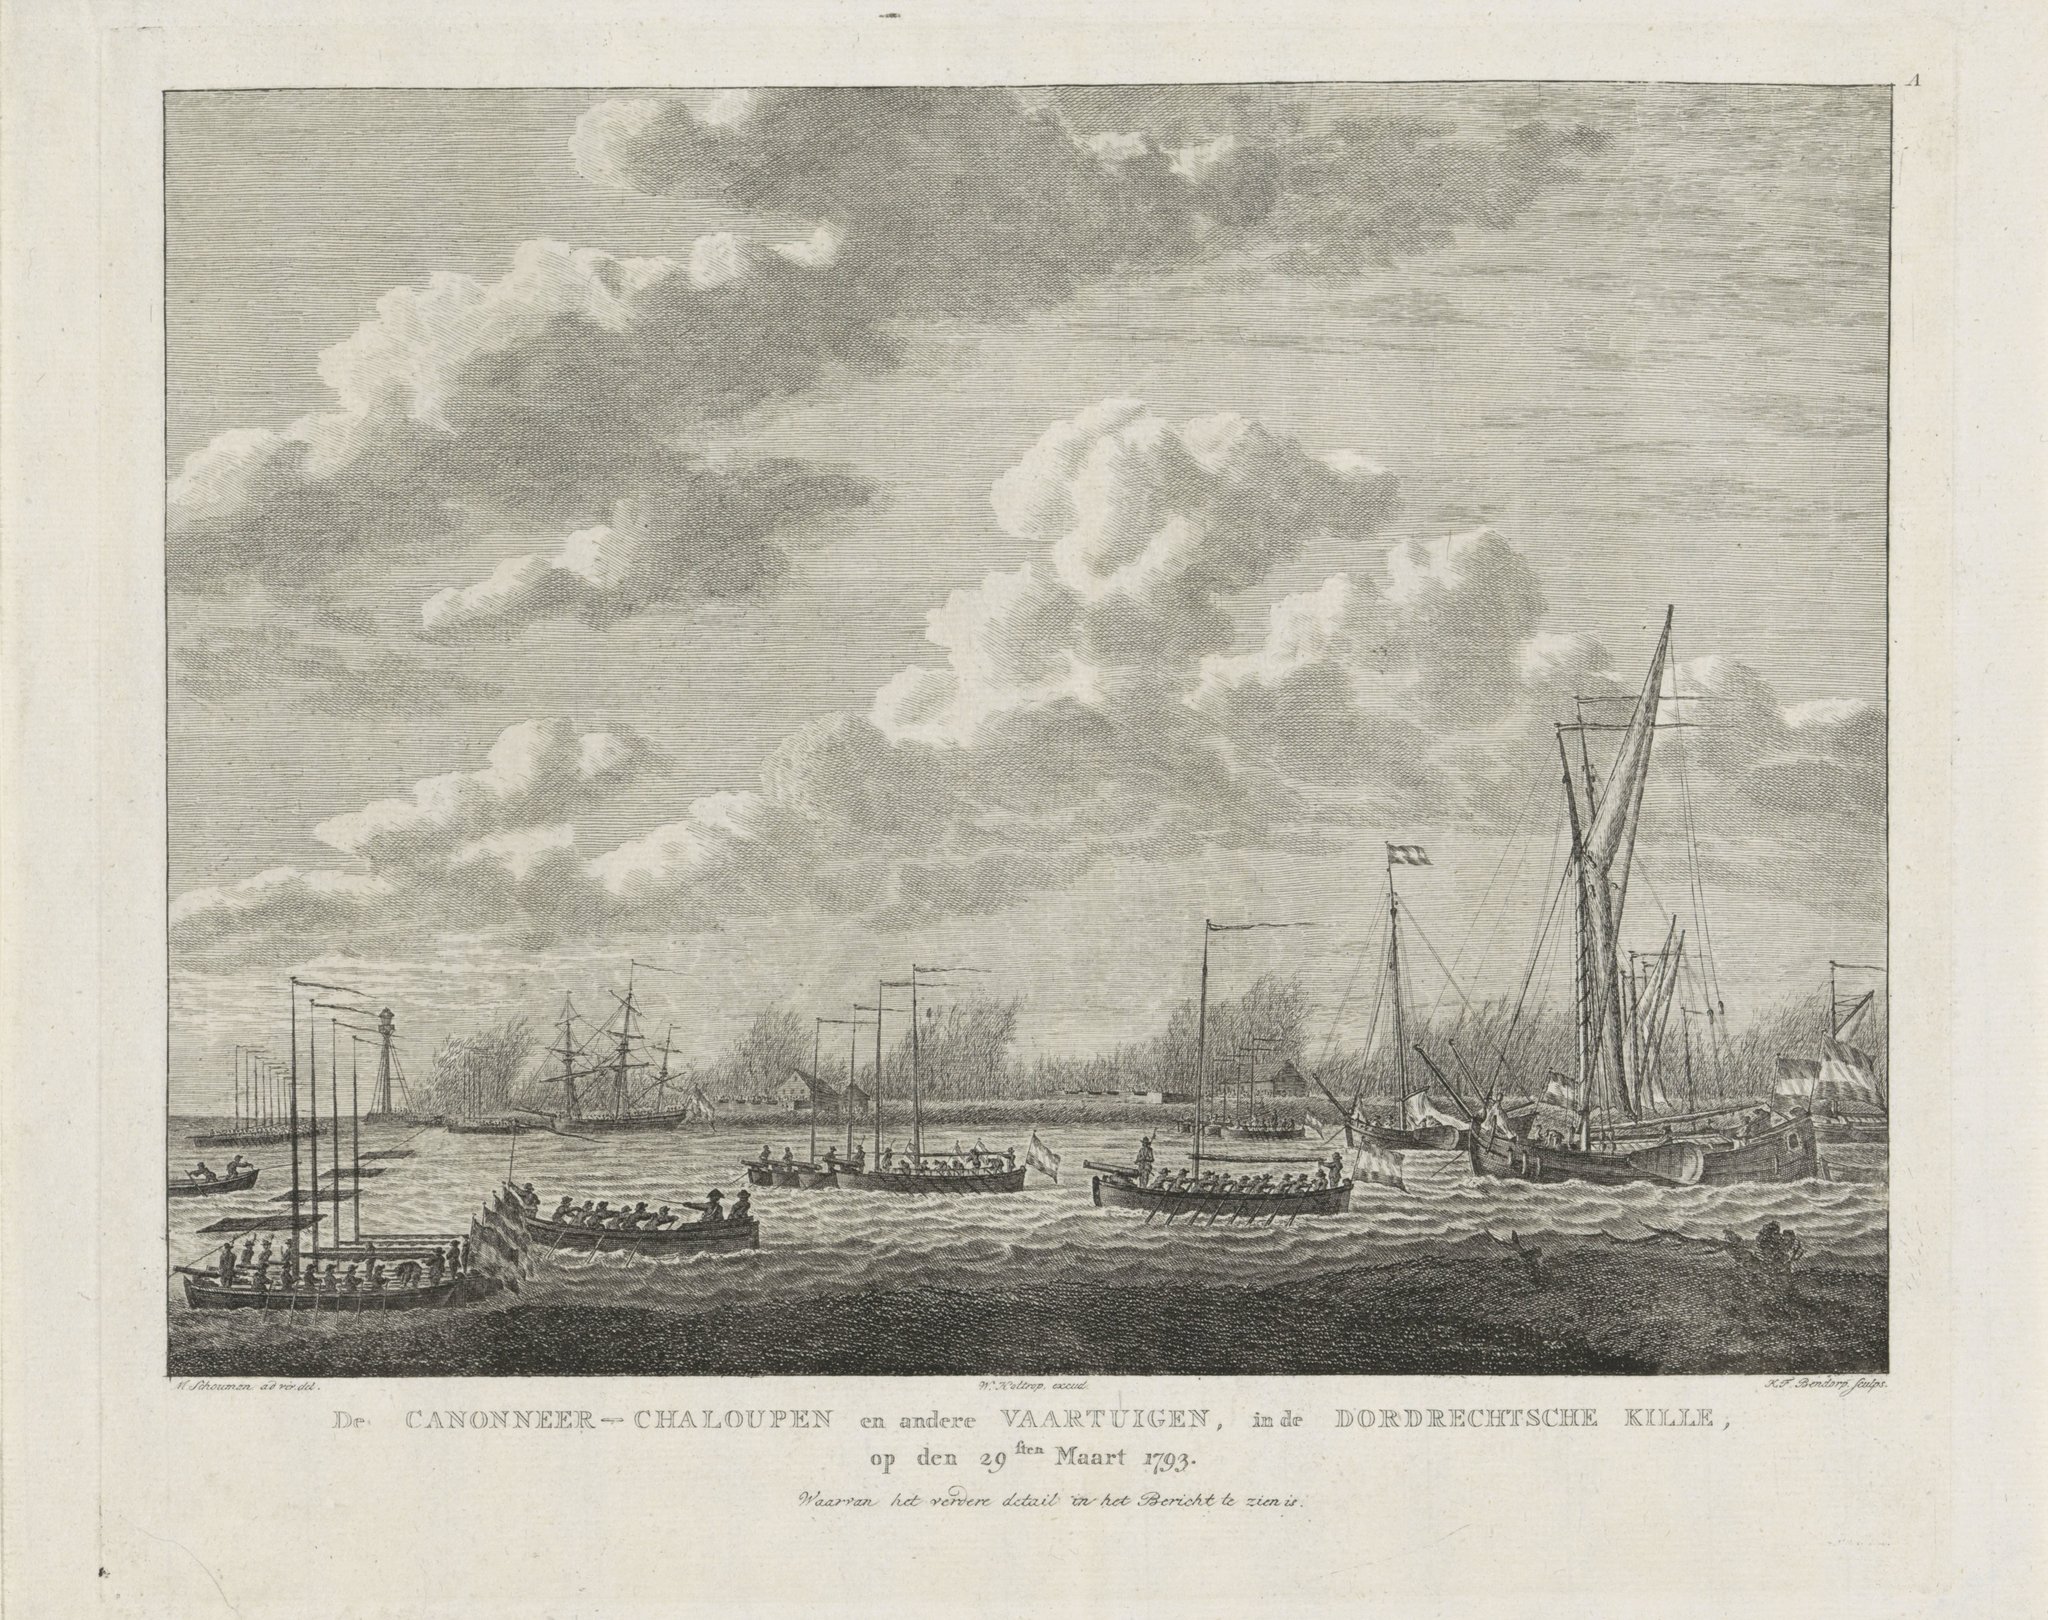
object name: print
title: Kanonneersloepen in de Dordtsche Kil, 1793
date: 1793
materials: paper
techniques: engraving, etching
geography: dordtse kil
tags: chains across waterway, rowing-boat, canoe, etc.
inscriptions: collector's mark: Lugt 2228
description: De afsluiting van de Dordtsche Kil met vlotten, kanonneersloepen en enkele andere vaartuigen op 29 maart 1793, als verdediging tegen de Fransen. Gemerkt rechtsboven: A. Zie pendant.